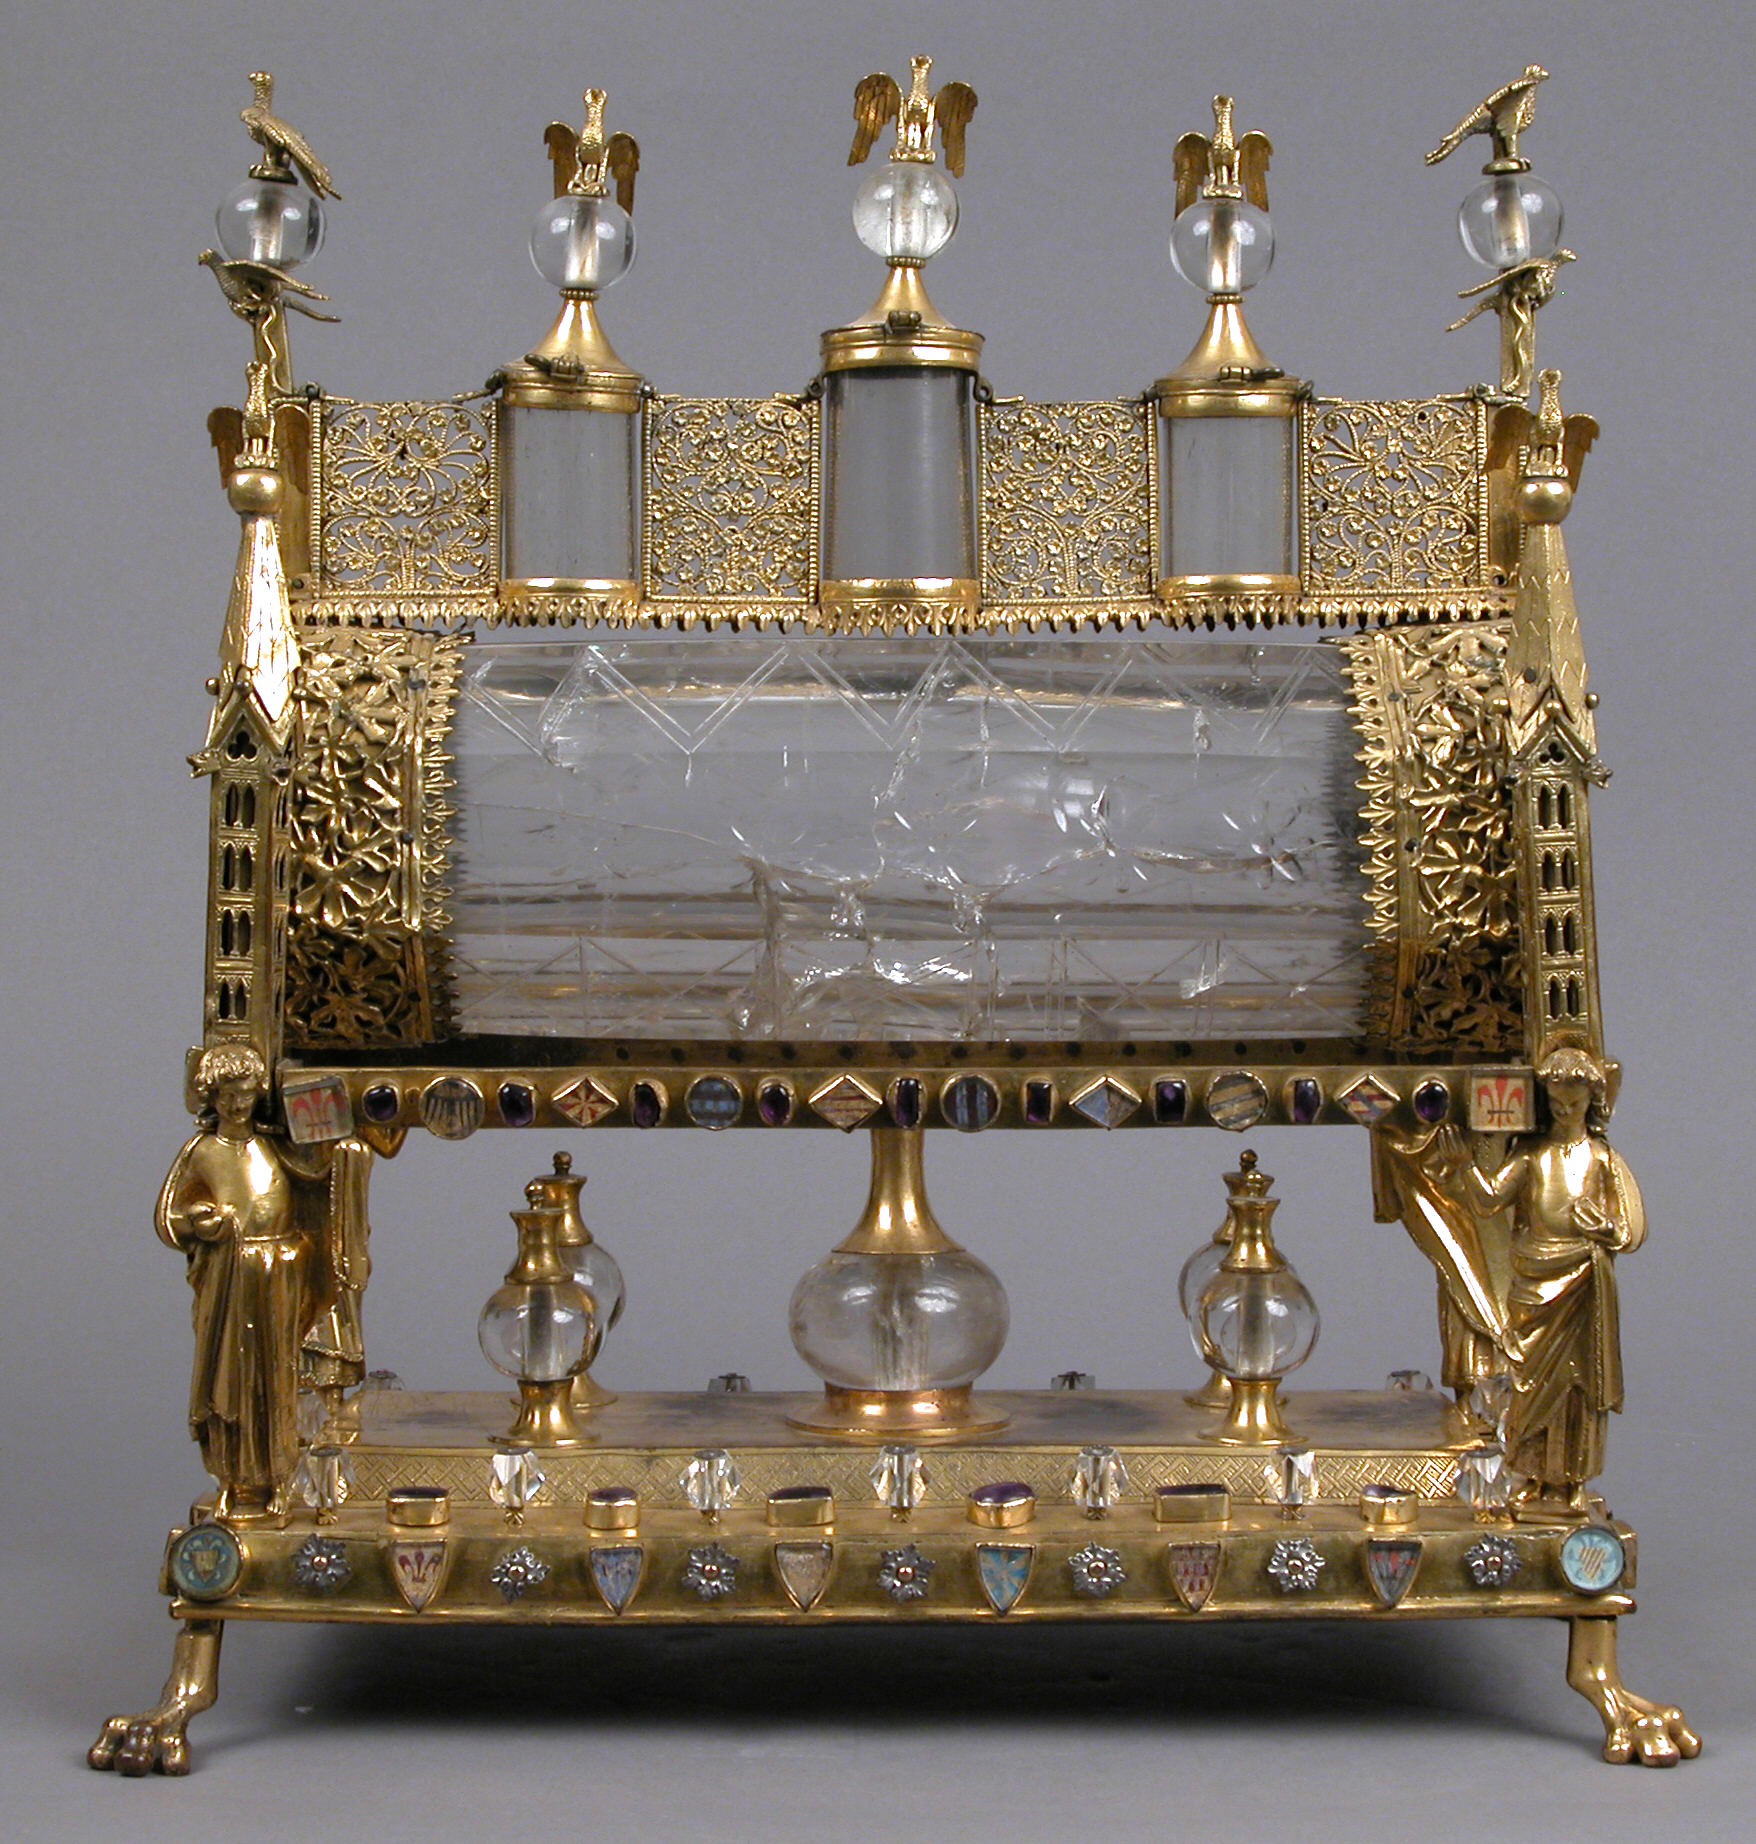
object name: reliquary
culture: french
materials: gilt copper, glass, parchment, quartz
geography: france